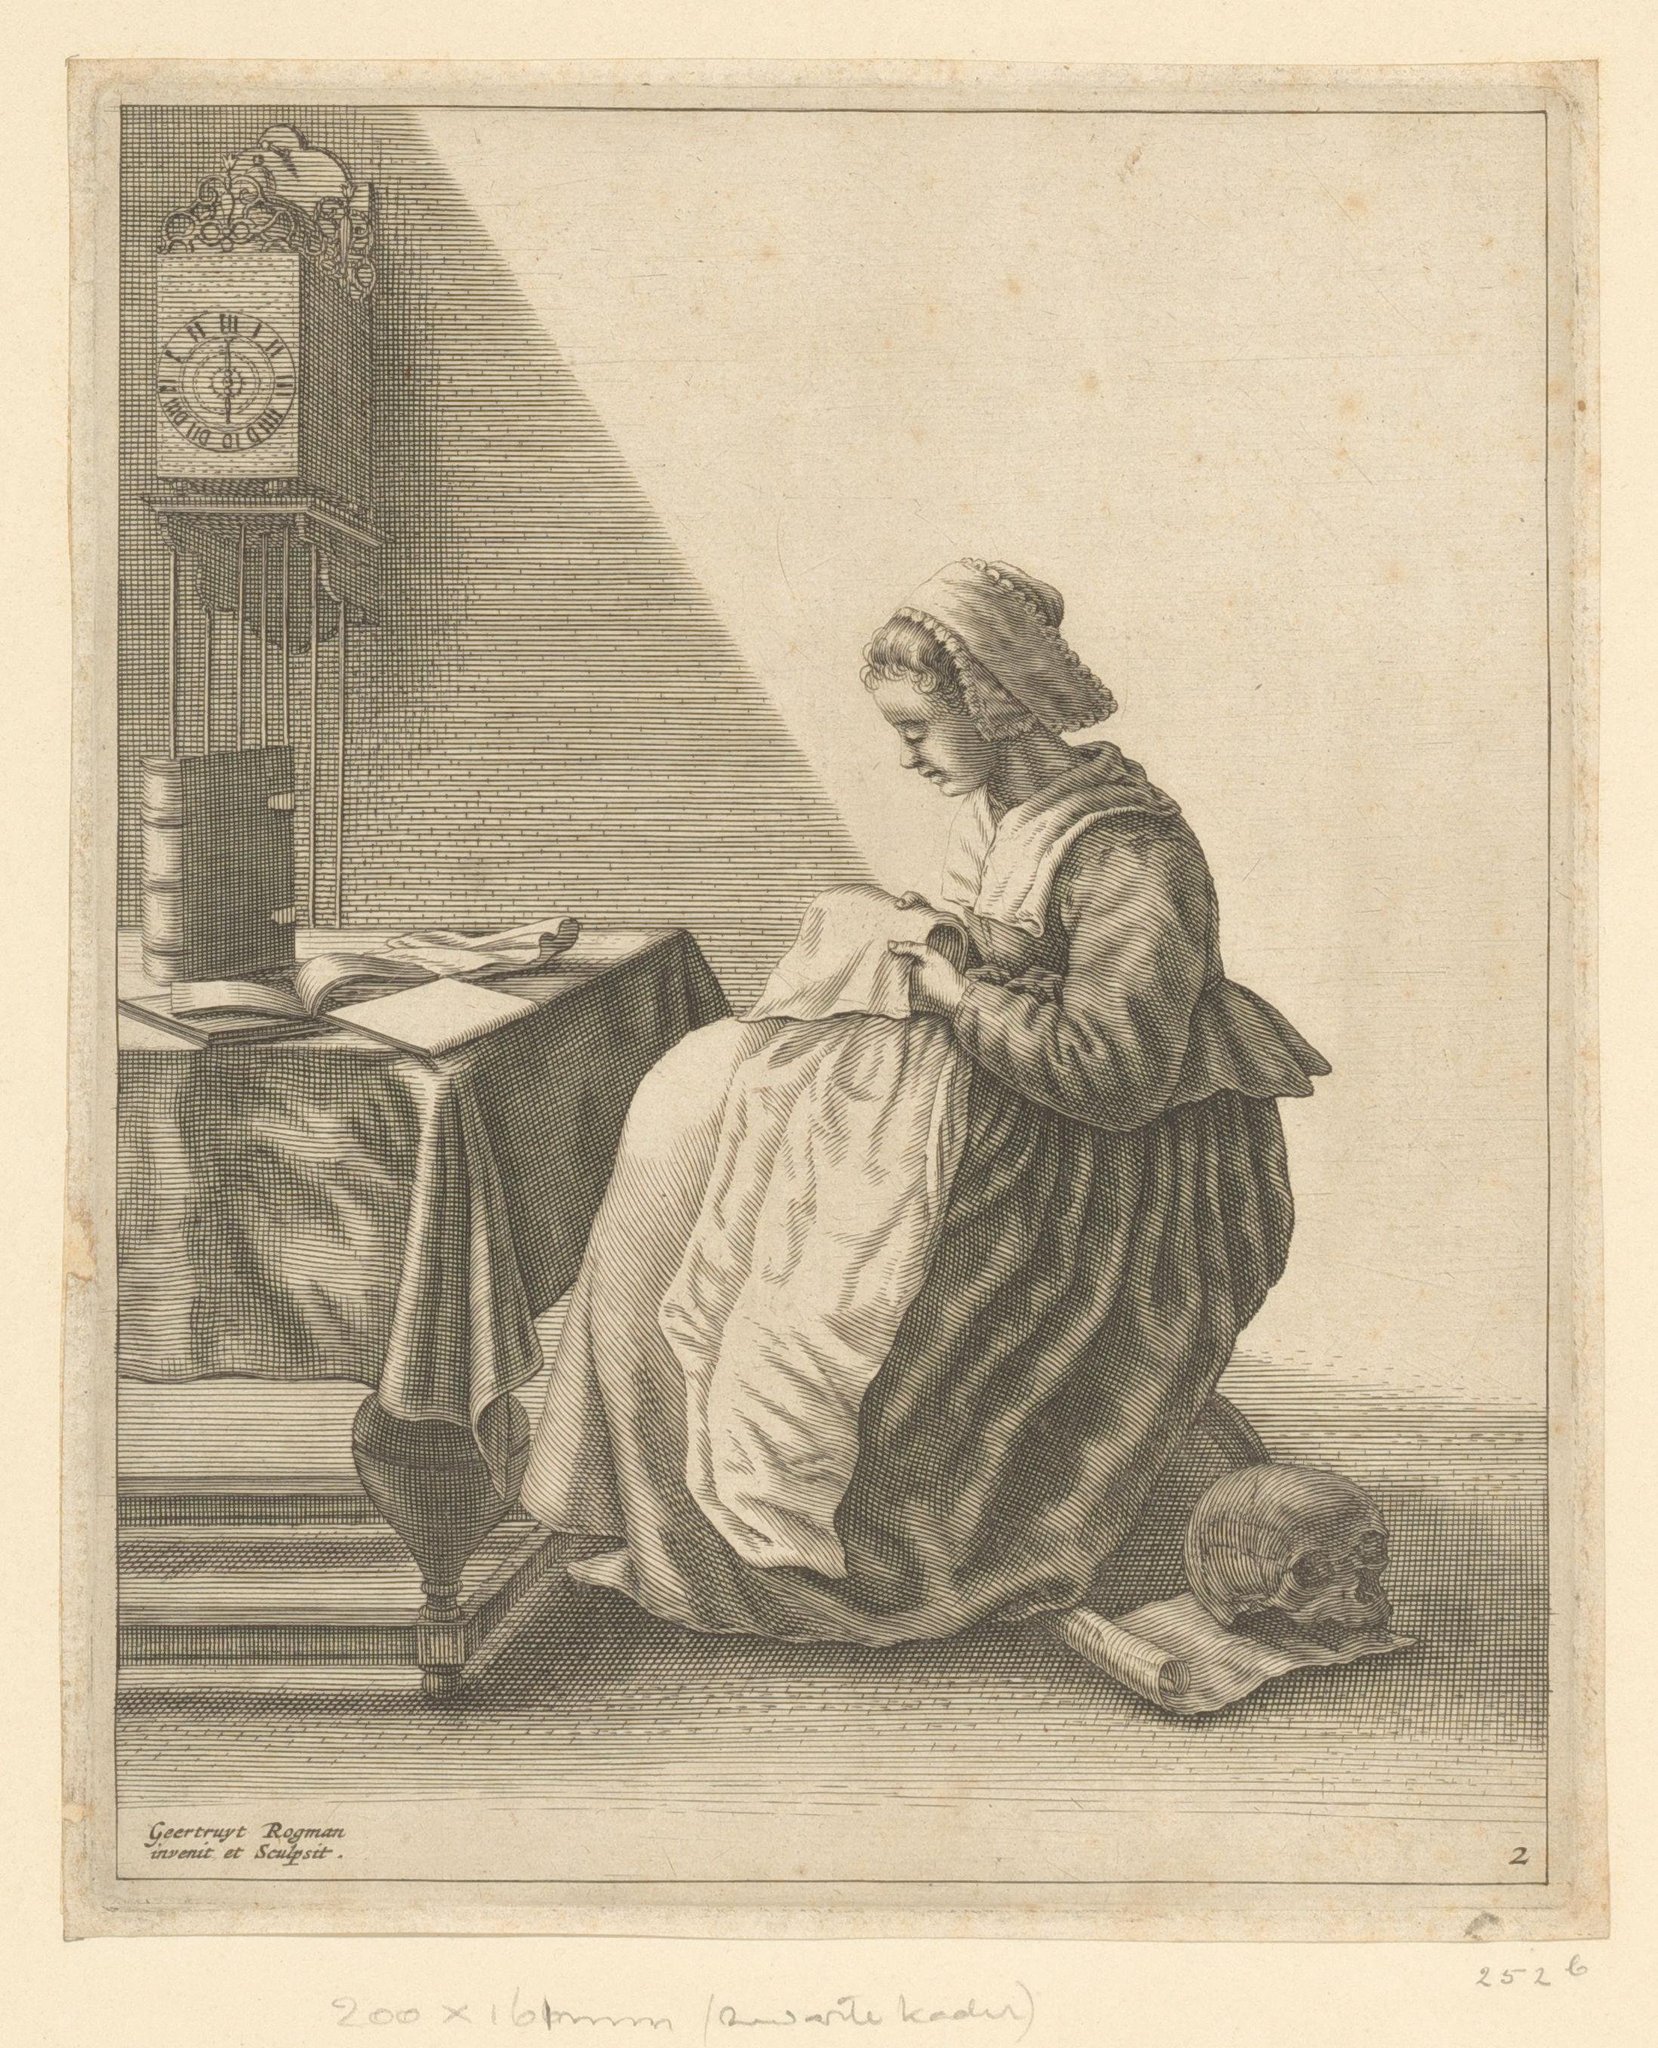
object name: print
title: Huiselijke werkzaamheden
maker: geertruydt roghman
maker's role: print maker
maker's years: 1625-1657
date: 1648-1650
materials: paper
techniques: engraving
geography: netherlands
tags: skull as symbol of 'vanitas', clock, home sewing; repair of clothes, death's head, skull (symbol of death)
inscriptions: collector's mark, collector's mark: Lugt 1641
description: Een jonge vrouw zit in een vertrek aan een tafel waarop enkele boeken, en is bezig met het vouwen van een kraag of een muts. Ze is gekleed volgens de burgerlijke mode van ca. 1640 en draagt een mutsje op het hoofd. Aan de wand hangt een klok. Op de grond, achter haar stoel, ligt een doodshoofd op een rol papier. Rechtsonder genummerd: 2. De prent maakt deel uit van een serie van vijf prenten met huiselijke werkzaamheden. Onderwerpsrubrieken binnen de Atlas Zeden en Gewoonten: Beroep en bedrijf. Vrouwelijk beroep en bedrijf. Kleding.